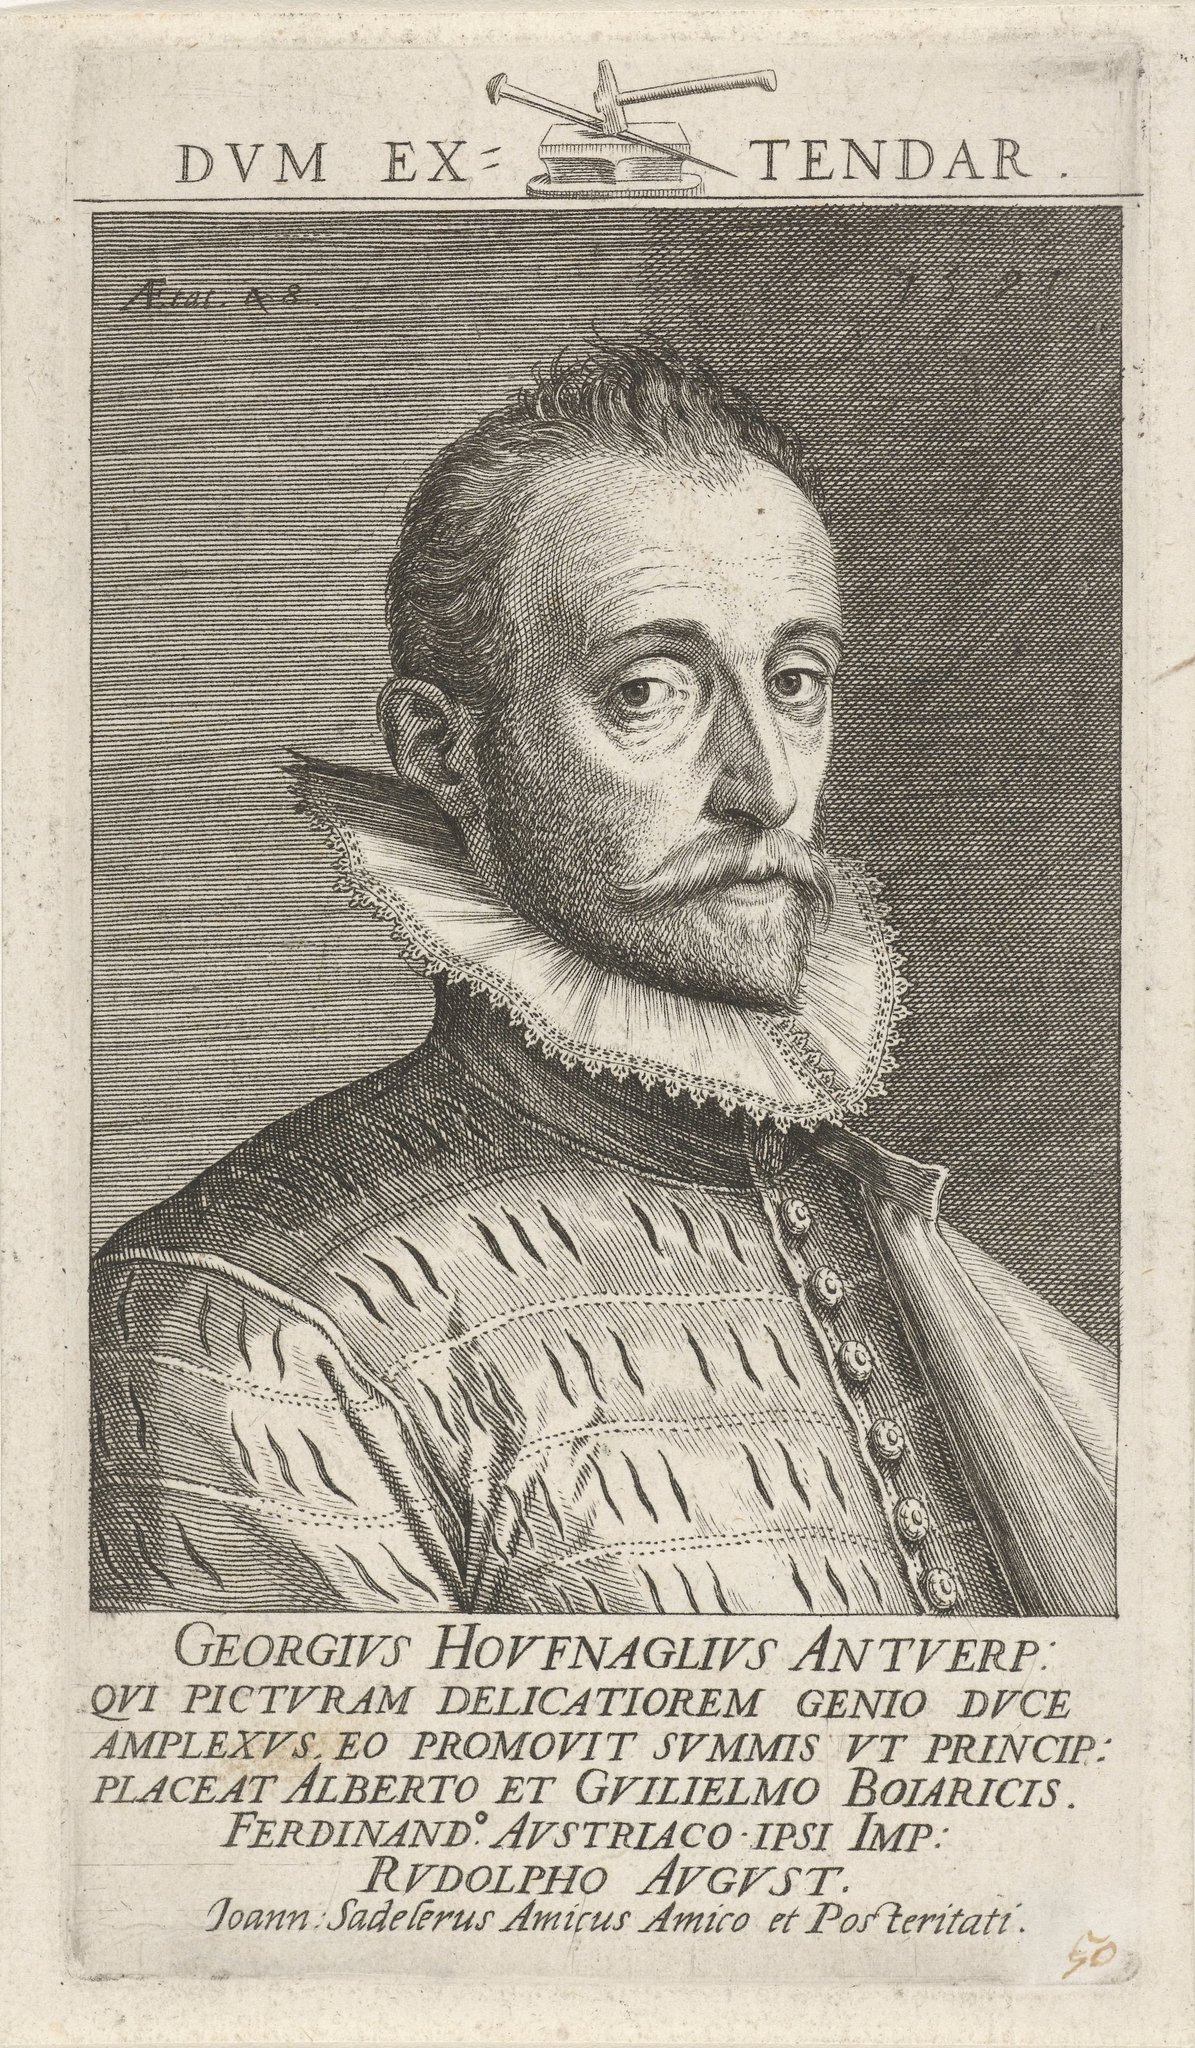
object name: print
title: Portret van Joris Hoefnagel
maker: johann sadeler (i)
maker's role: print maker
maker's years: 1550-1600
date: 1592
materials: paper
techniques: engraving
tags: antwerp, vienna, painter, joris hoefnagel, neck-gear ~ clothing (with name) (+ men's clothes), portrait, self-portrait of painter, tools, aids, implements ~ crafts and industries: anvil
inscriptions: number: ‘50’, collector's mark: Lugt 2760, collector's mark: Lugt 2228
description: Portret van de schilder Joris Hoefnagel op 48-jarige leeftijd, gekleed in wambuis met spleten, waarboven opstaande kraag afgezet met kant. Boven het portret zijn devies (hamer, graveerpent en aambeeld) en zijn motto: 'Dum ex tendar'.